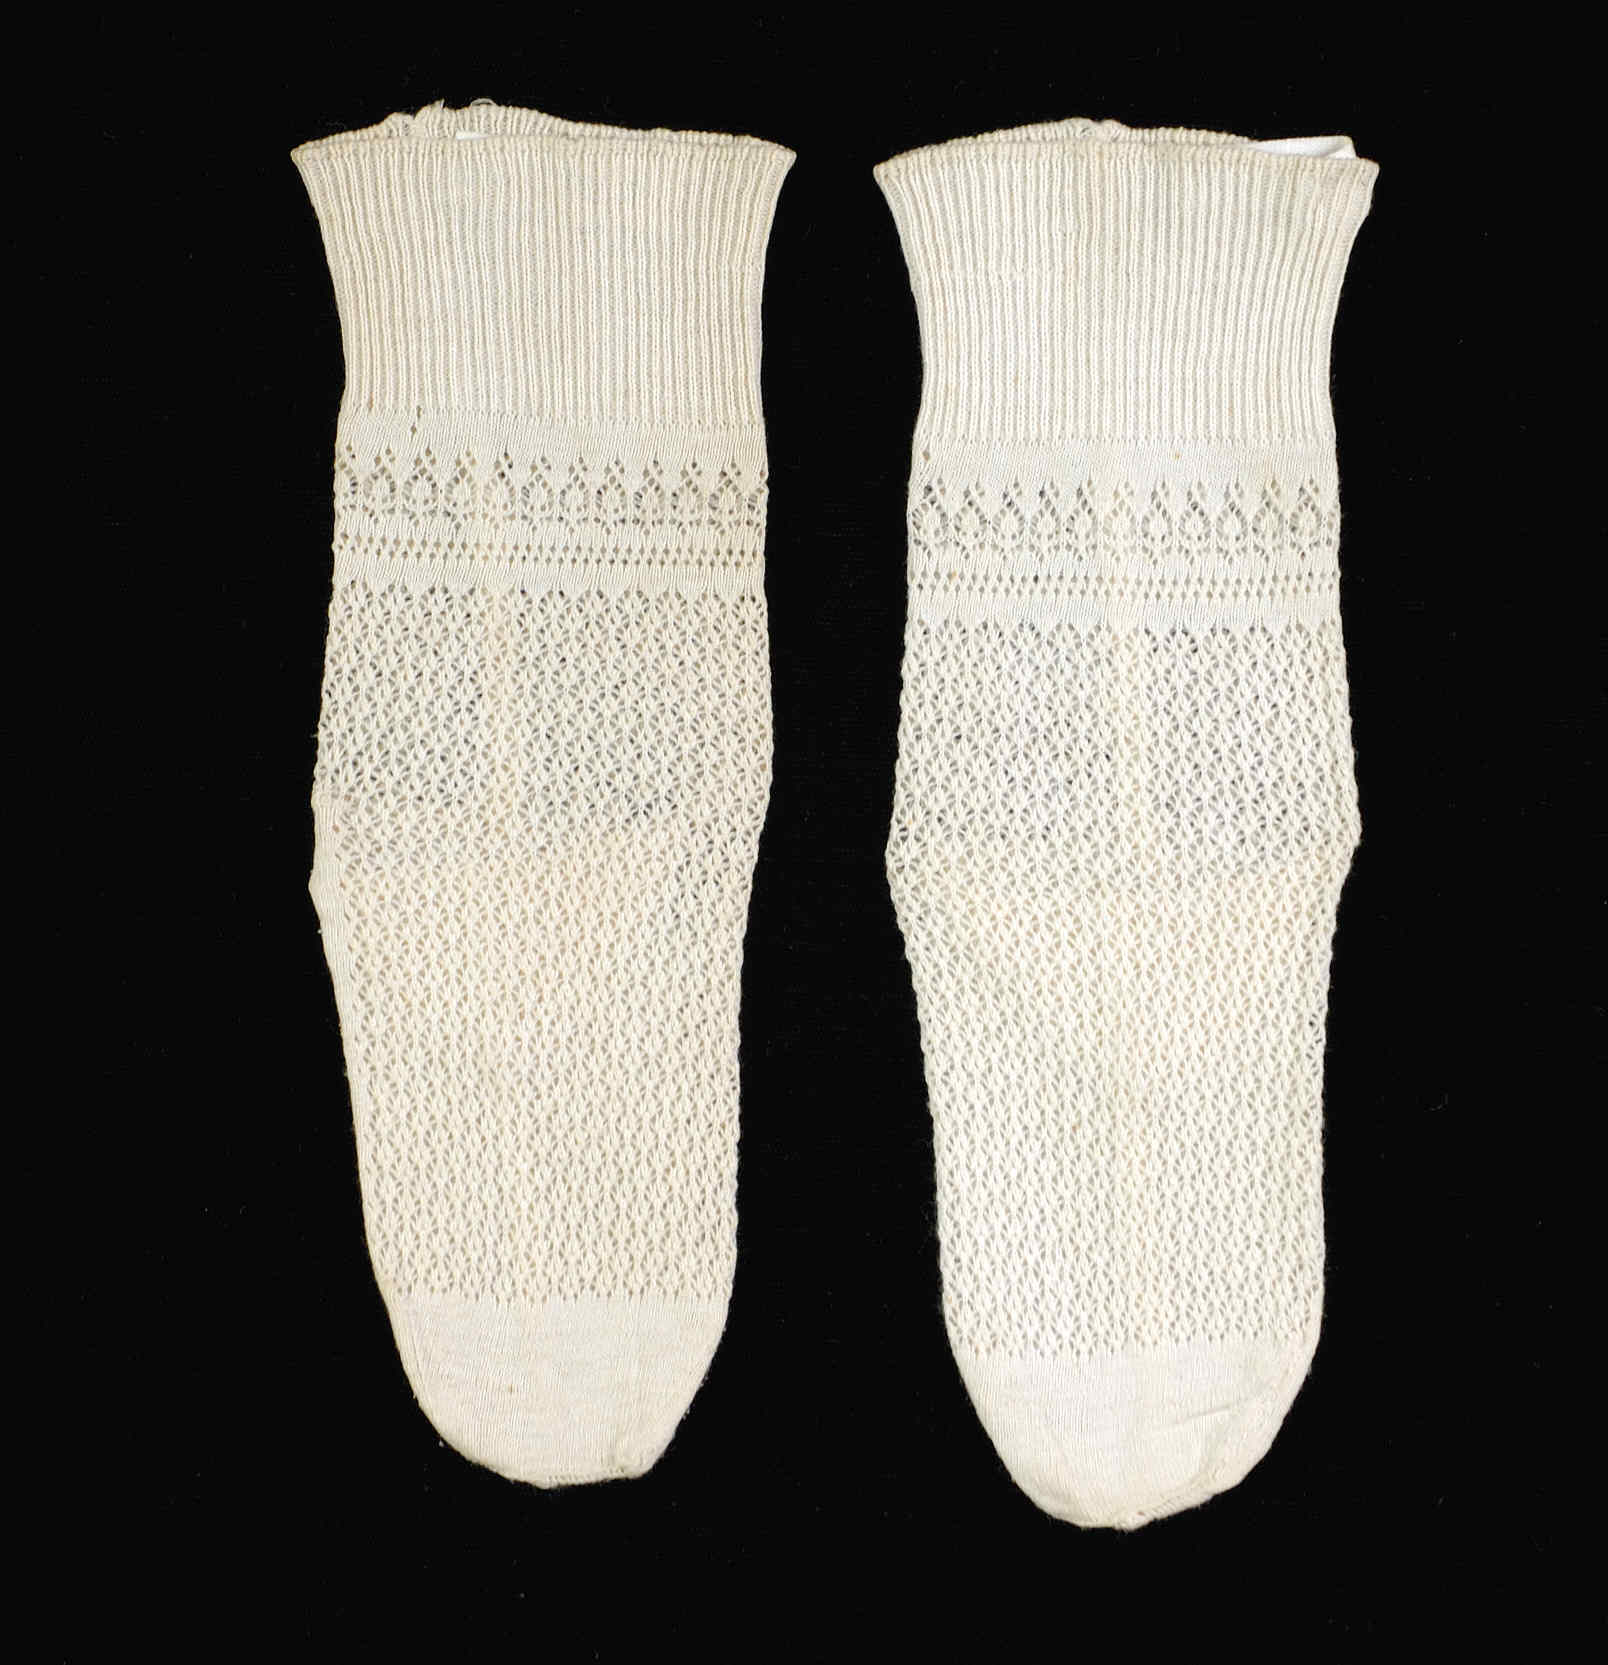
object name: sock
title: Socks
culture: american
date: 1840-1860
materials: cotton